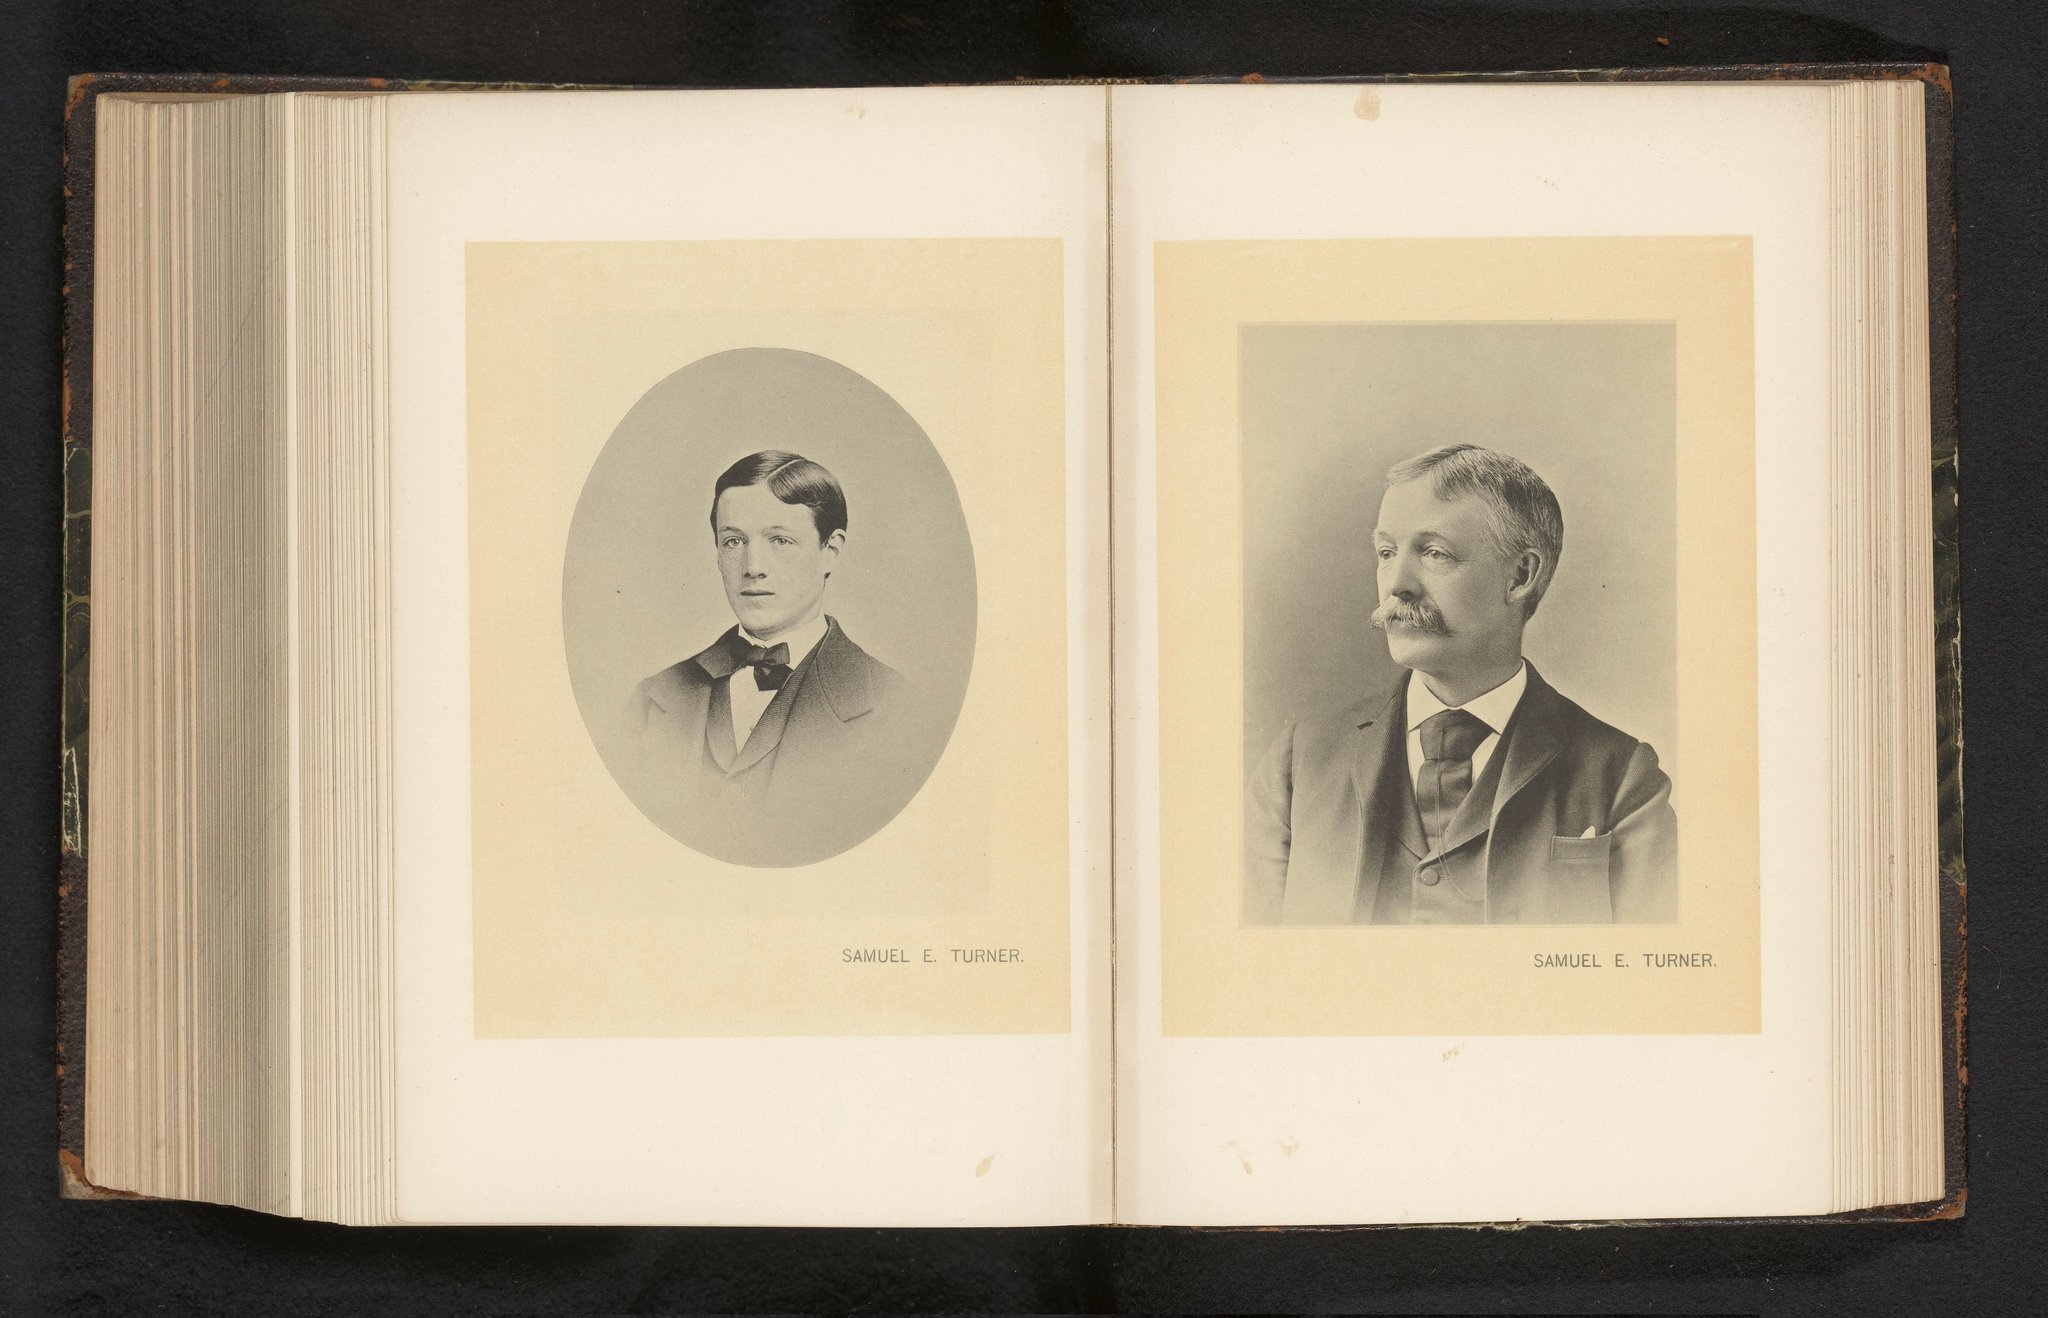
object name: page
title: Samuel E. Turner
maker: Anonymous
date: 1889-1894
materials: paper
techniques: photoaquatint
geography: boston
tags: adult man